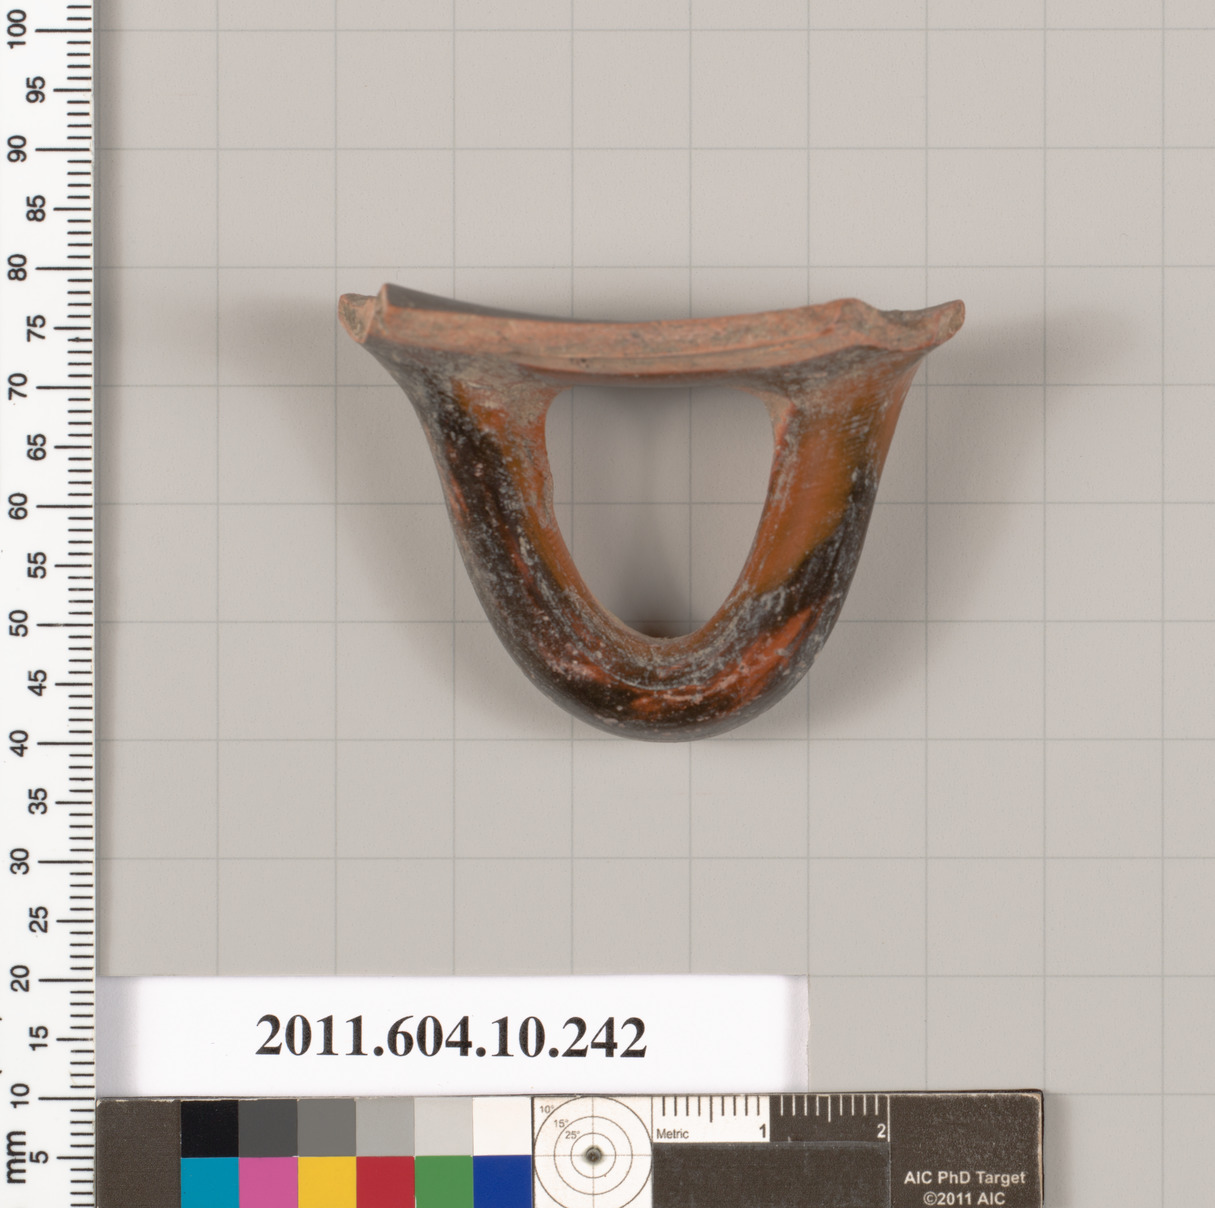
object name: skyphos fragment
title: Terracotta fragment of a skyphos (deep drinking cup)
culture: etruscan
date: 600-401 BCE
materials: terracotta